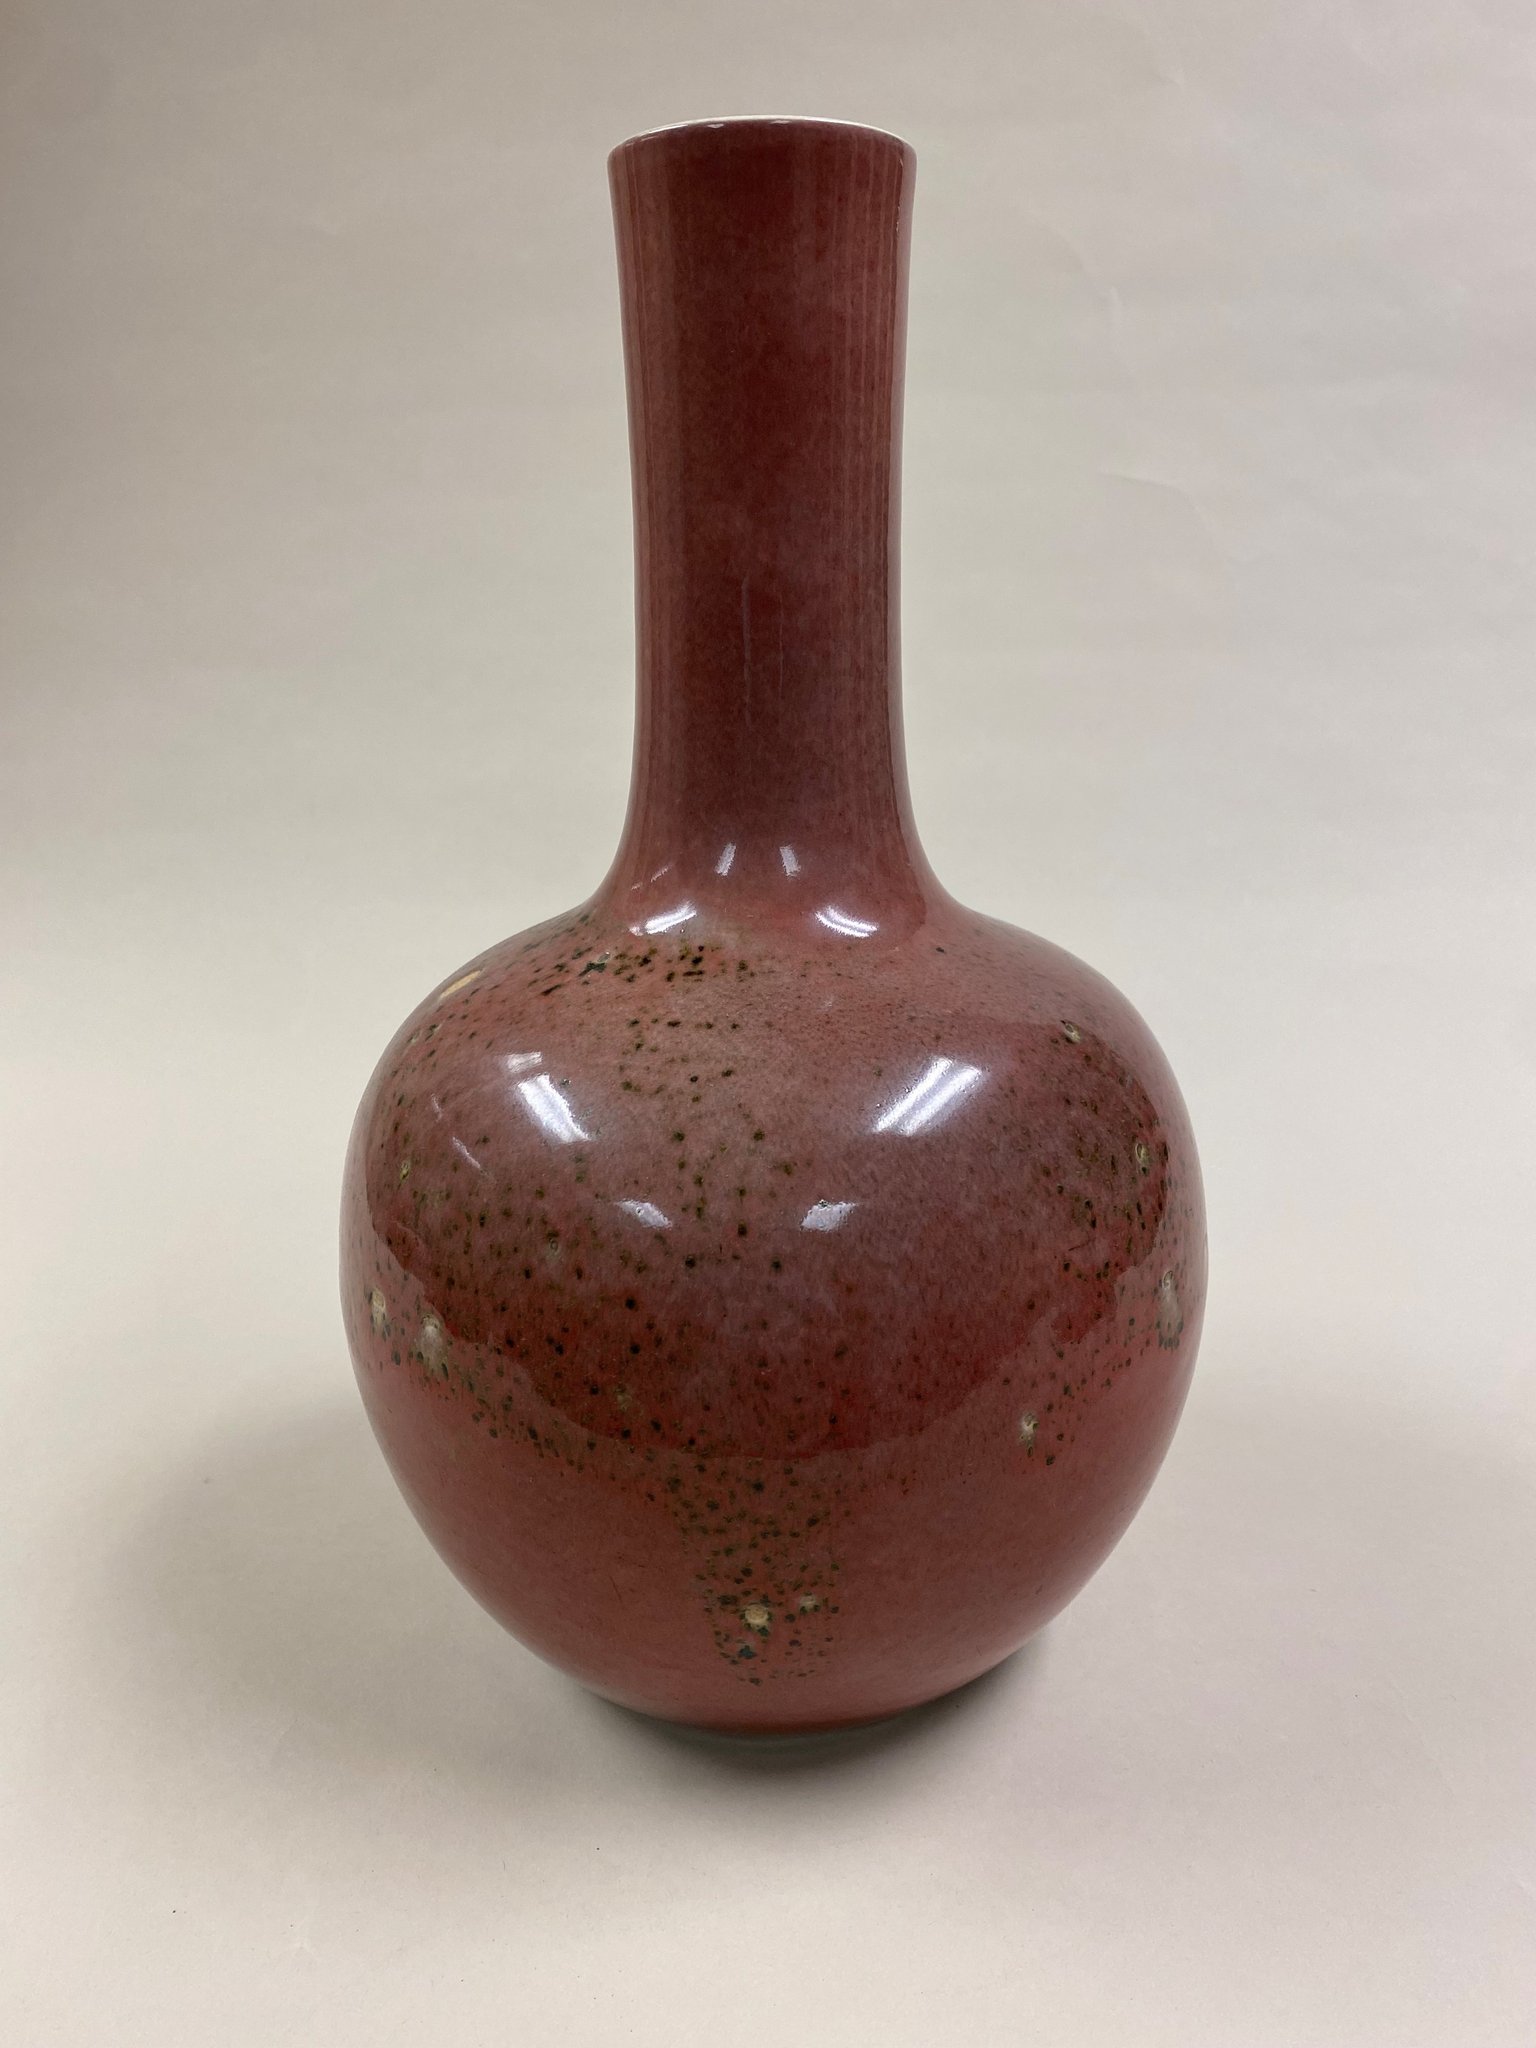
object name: bottle vase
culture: chinese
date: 1701-1800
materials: copper, glaze, porcelain